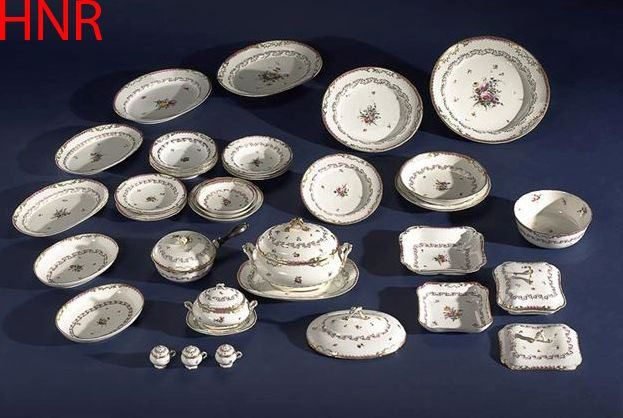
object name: plate dish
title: Bord, diep model, behorend bij een servies met geslingerd lintmotief met bladertakken, bloemboeketten en gestrooide bloemtakken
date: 1780-1820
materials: porcelain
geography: loosdrecht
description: Bord, diep model, behorend bij een servies van porselein met geslingerd lintmotief in paars en goud met groene bladertakken, bloemboeketten en gestrooide bloemtakken. Randen lichtgegolfd met decoratie in goud met paars bladmotief waartussen groen gekruist bladmotief. Gemerkt: M.O.L. en Amstel. Serie van vijftien stuks.